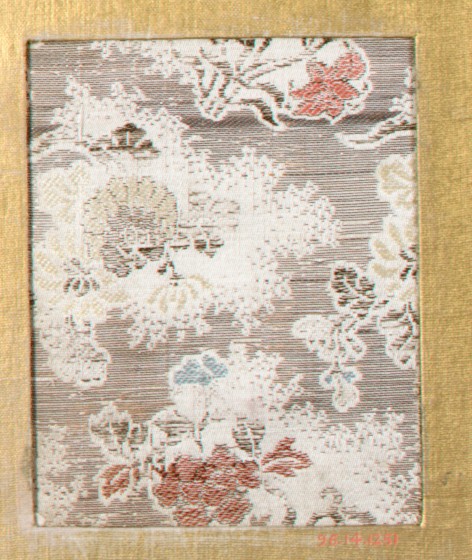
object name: piece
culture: japanese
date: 1701-1900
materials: silk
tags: flowers